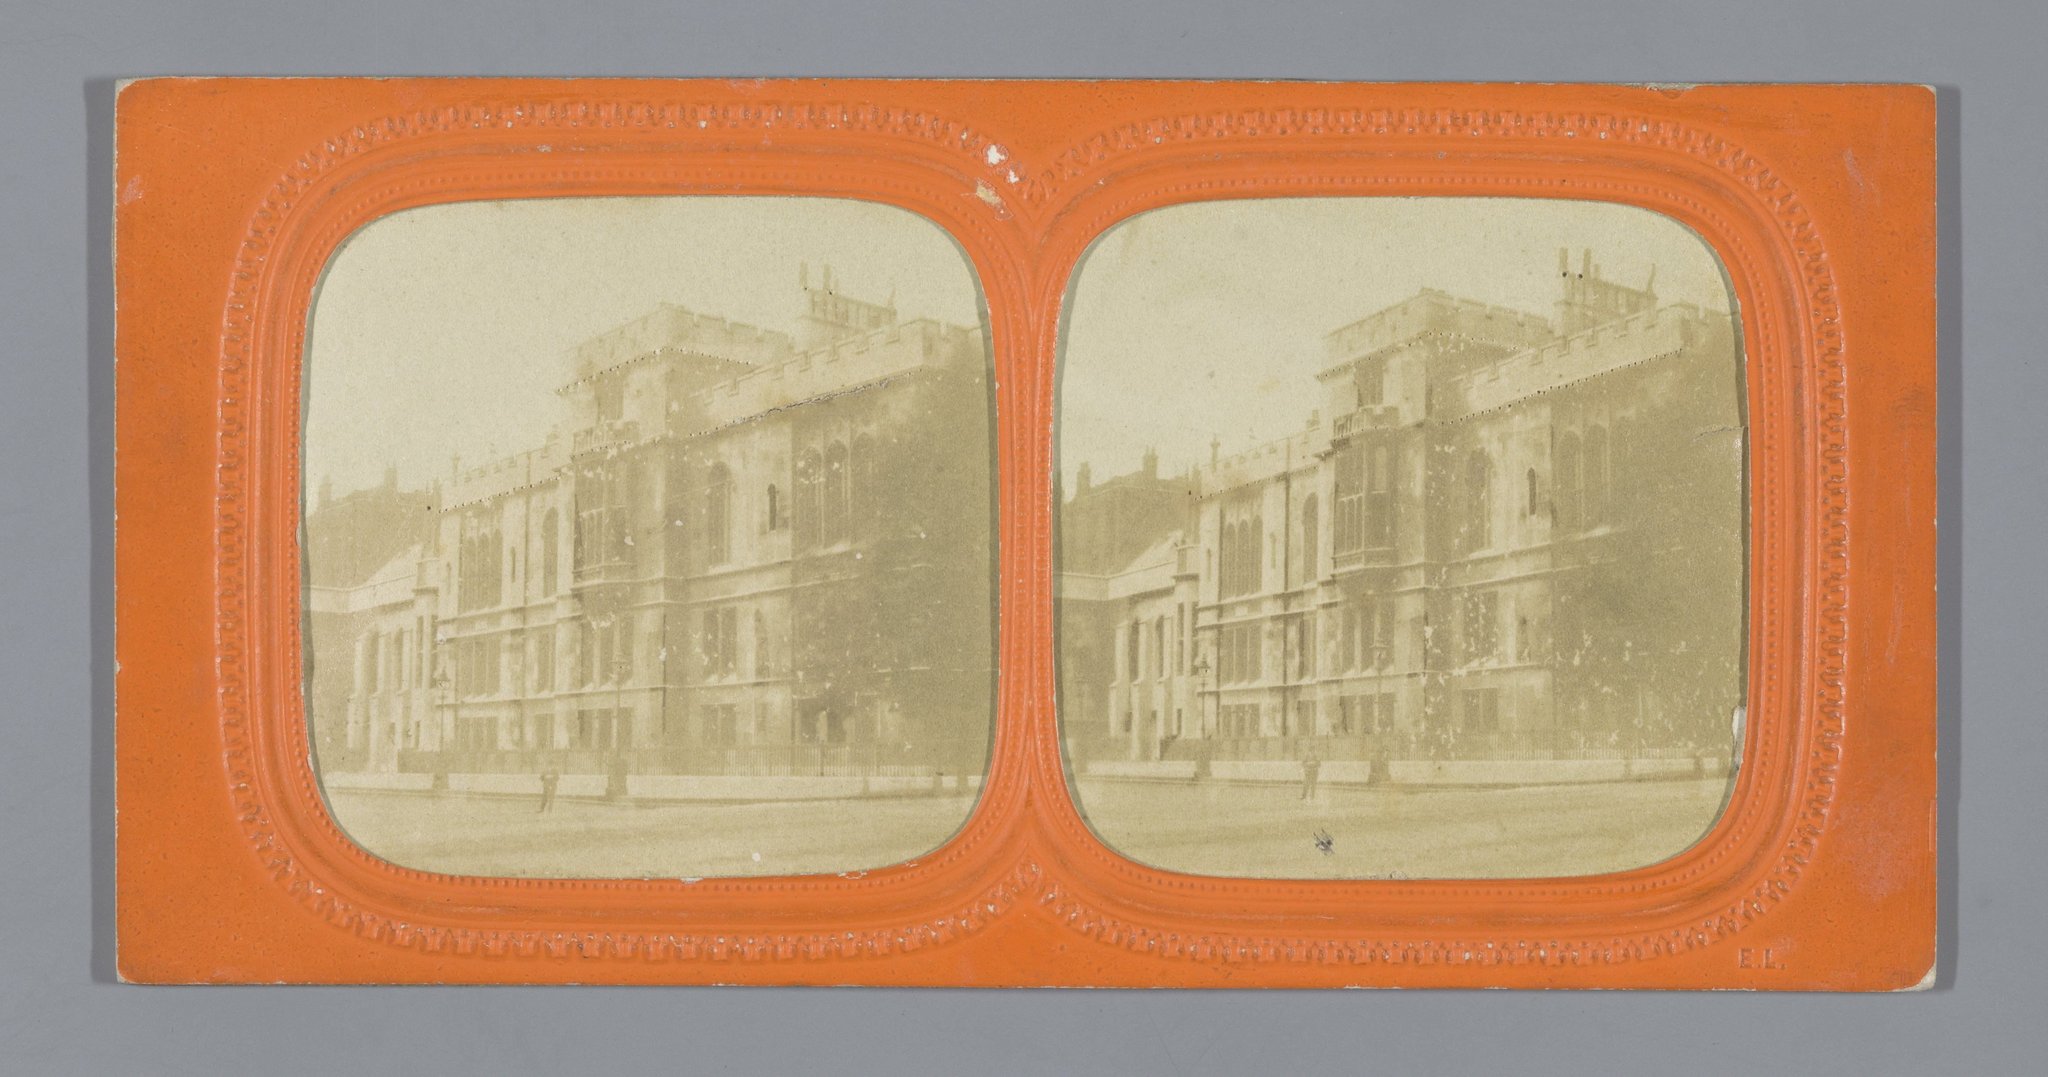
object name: tissue stereograph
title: Straatbeeld in Londen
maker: Anonymous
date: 1855-1875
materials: cardboard, paper, photographic support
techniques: albumen print, hand coloring, perforating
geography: london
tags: façade (of house or building), street, london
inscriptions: monogram: ‘E.L.’